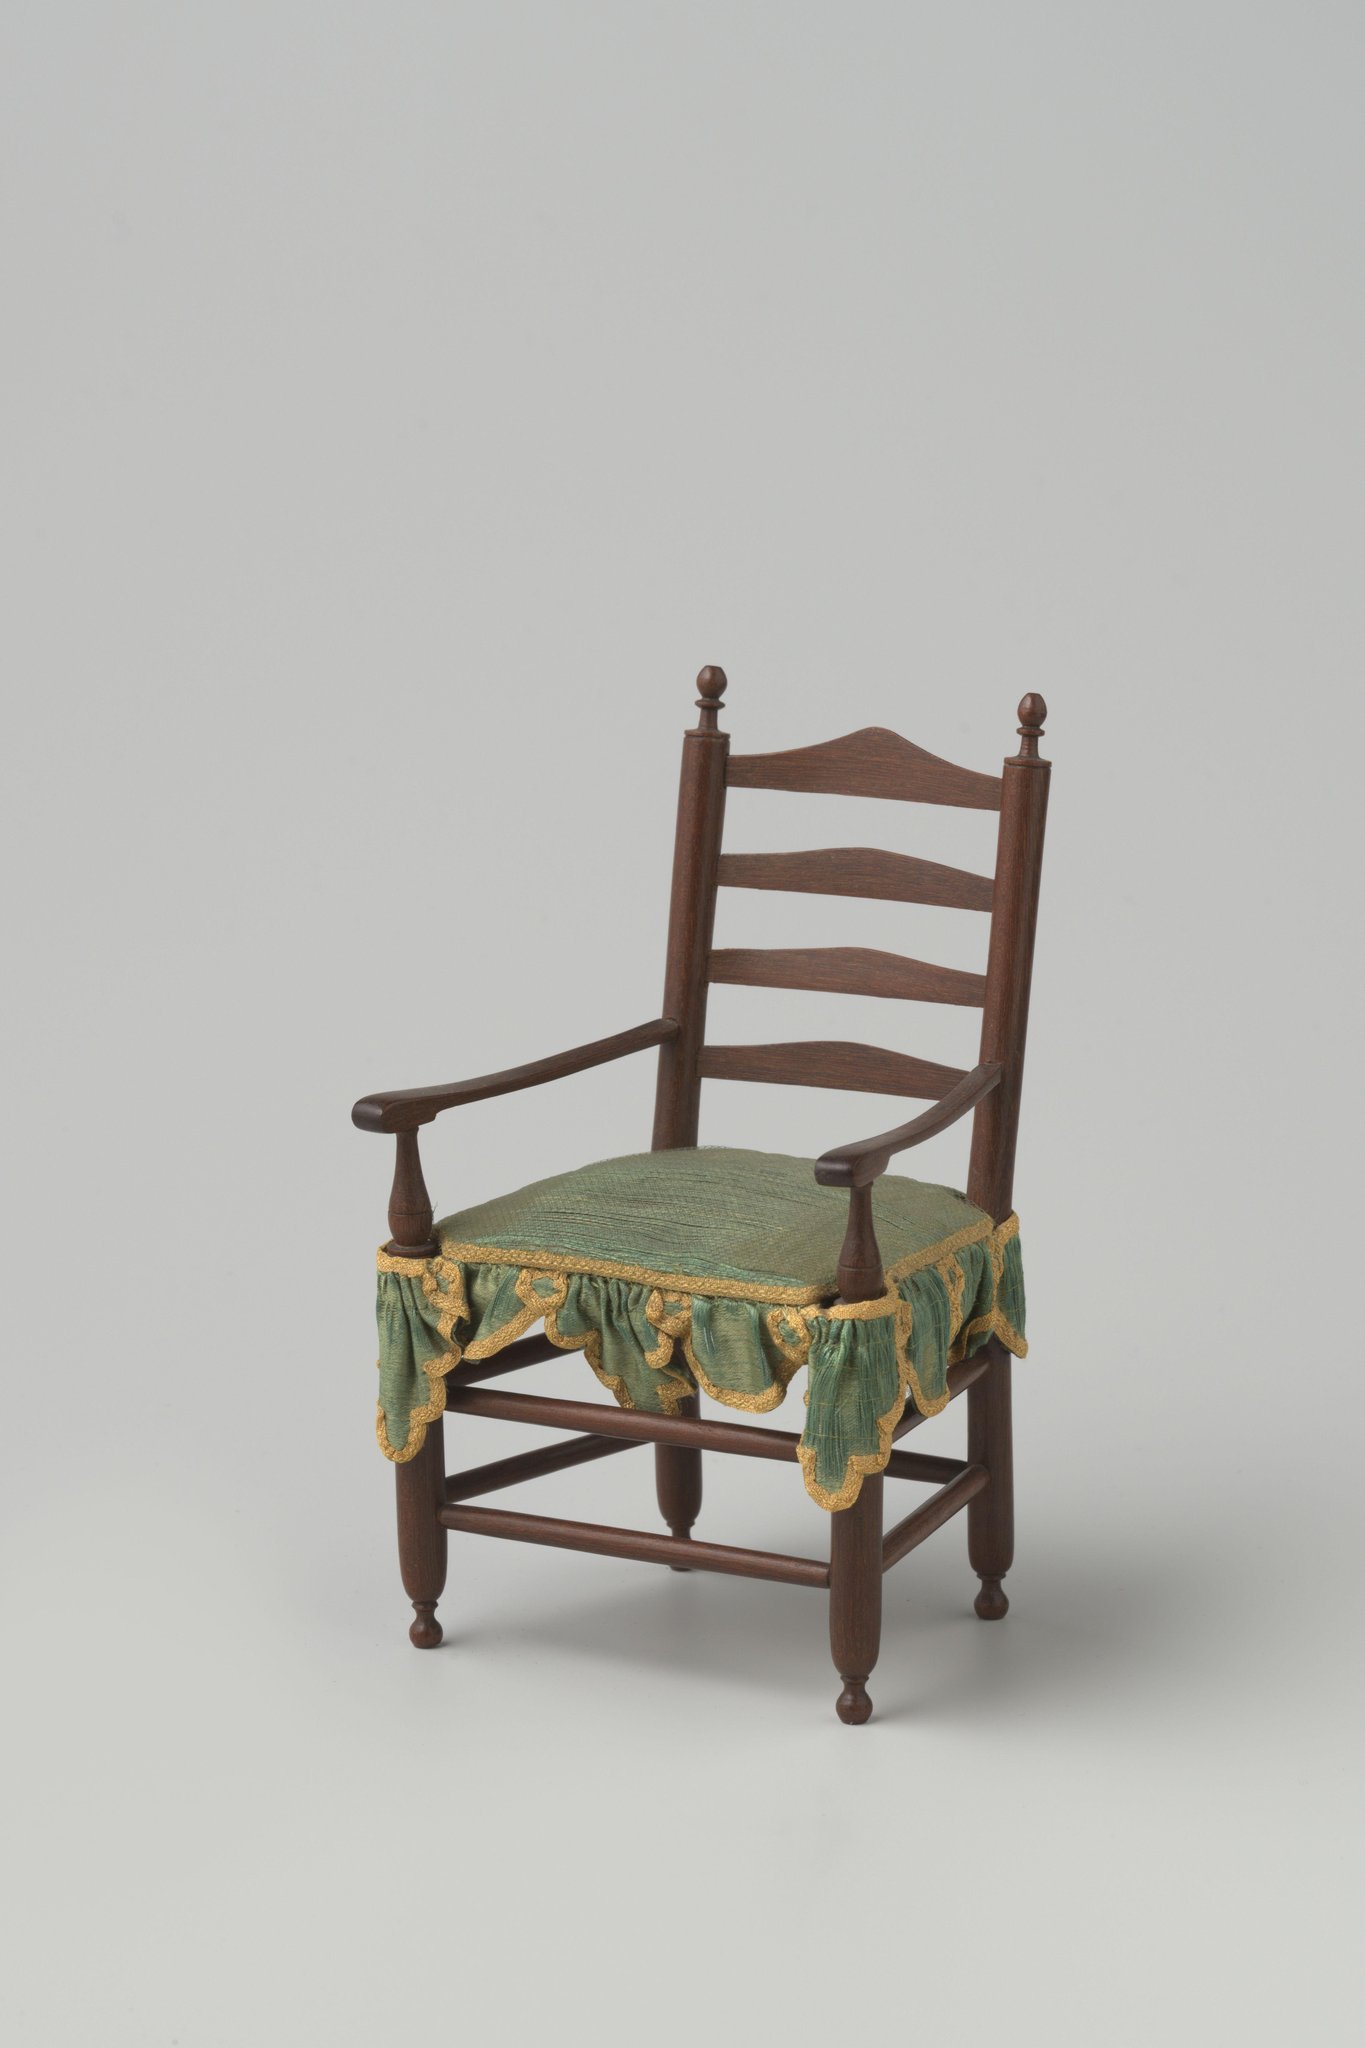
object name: chair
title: Knopstoel vervaardigd van hardhout met gladde, gedraaide stijlen en dwarsregels, voorpoten en achterstijlen eindigend in fijn gedraaide knoppen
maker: Anonymous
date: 1690-1710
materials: wood, silk, fiber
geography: amsterdam